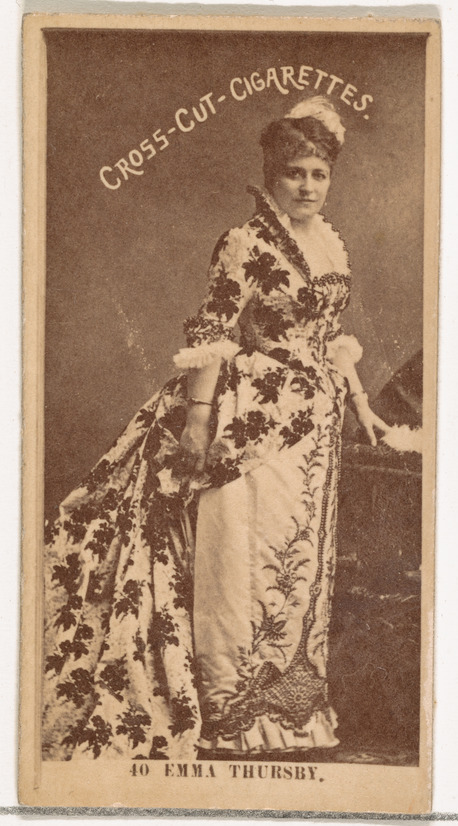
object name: print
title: Card Number 40, Emma Thursby, from the Actors and Actresses series (N145-2) issued by Duke Sons & Co. to promote Cross Cut Cigarettes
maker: w. duke, sons & co.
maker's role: publisher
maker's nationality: american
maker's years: 1870-1920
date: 1880-1889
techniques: albumen silver print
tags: portraits,women,actresses